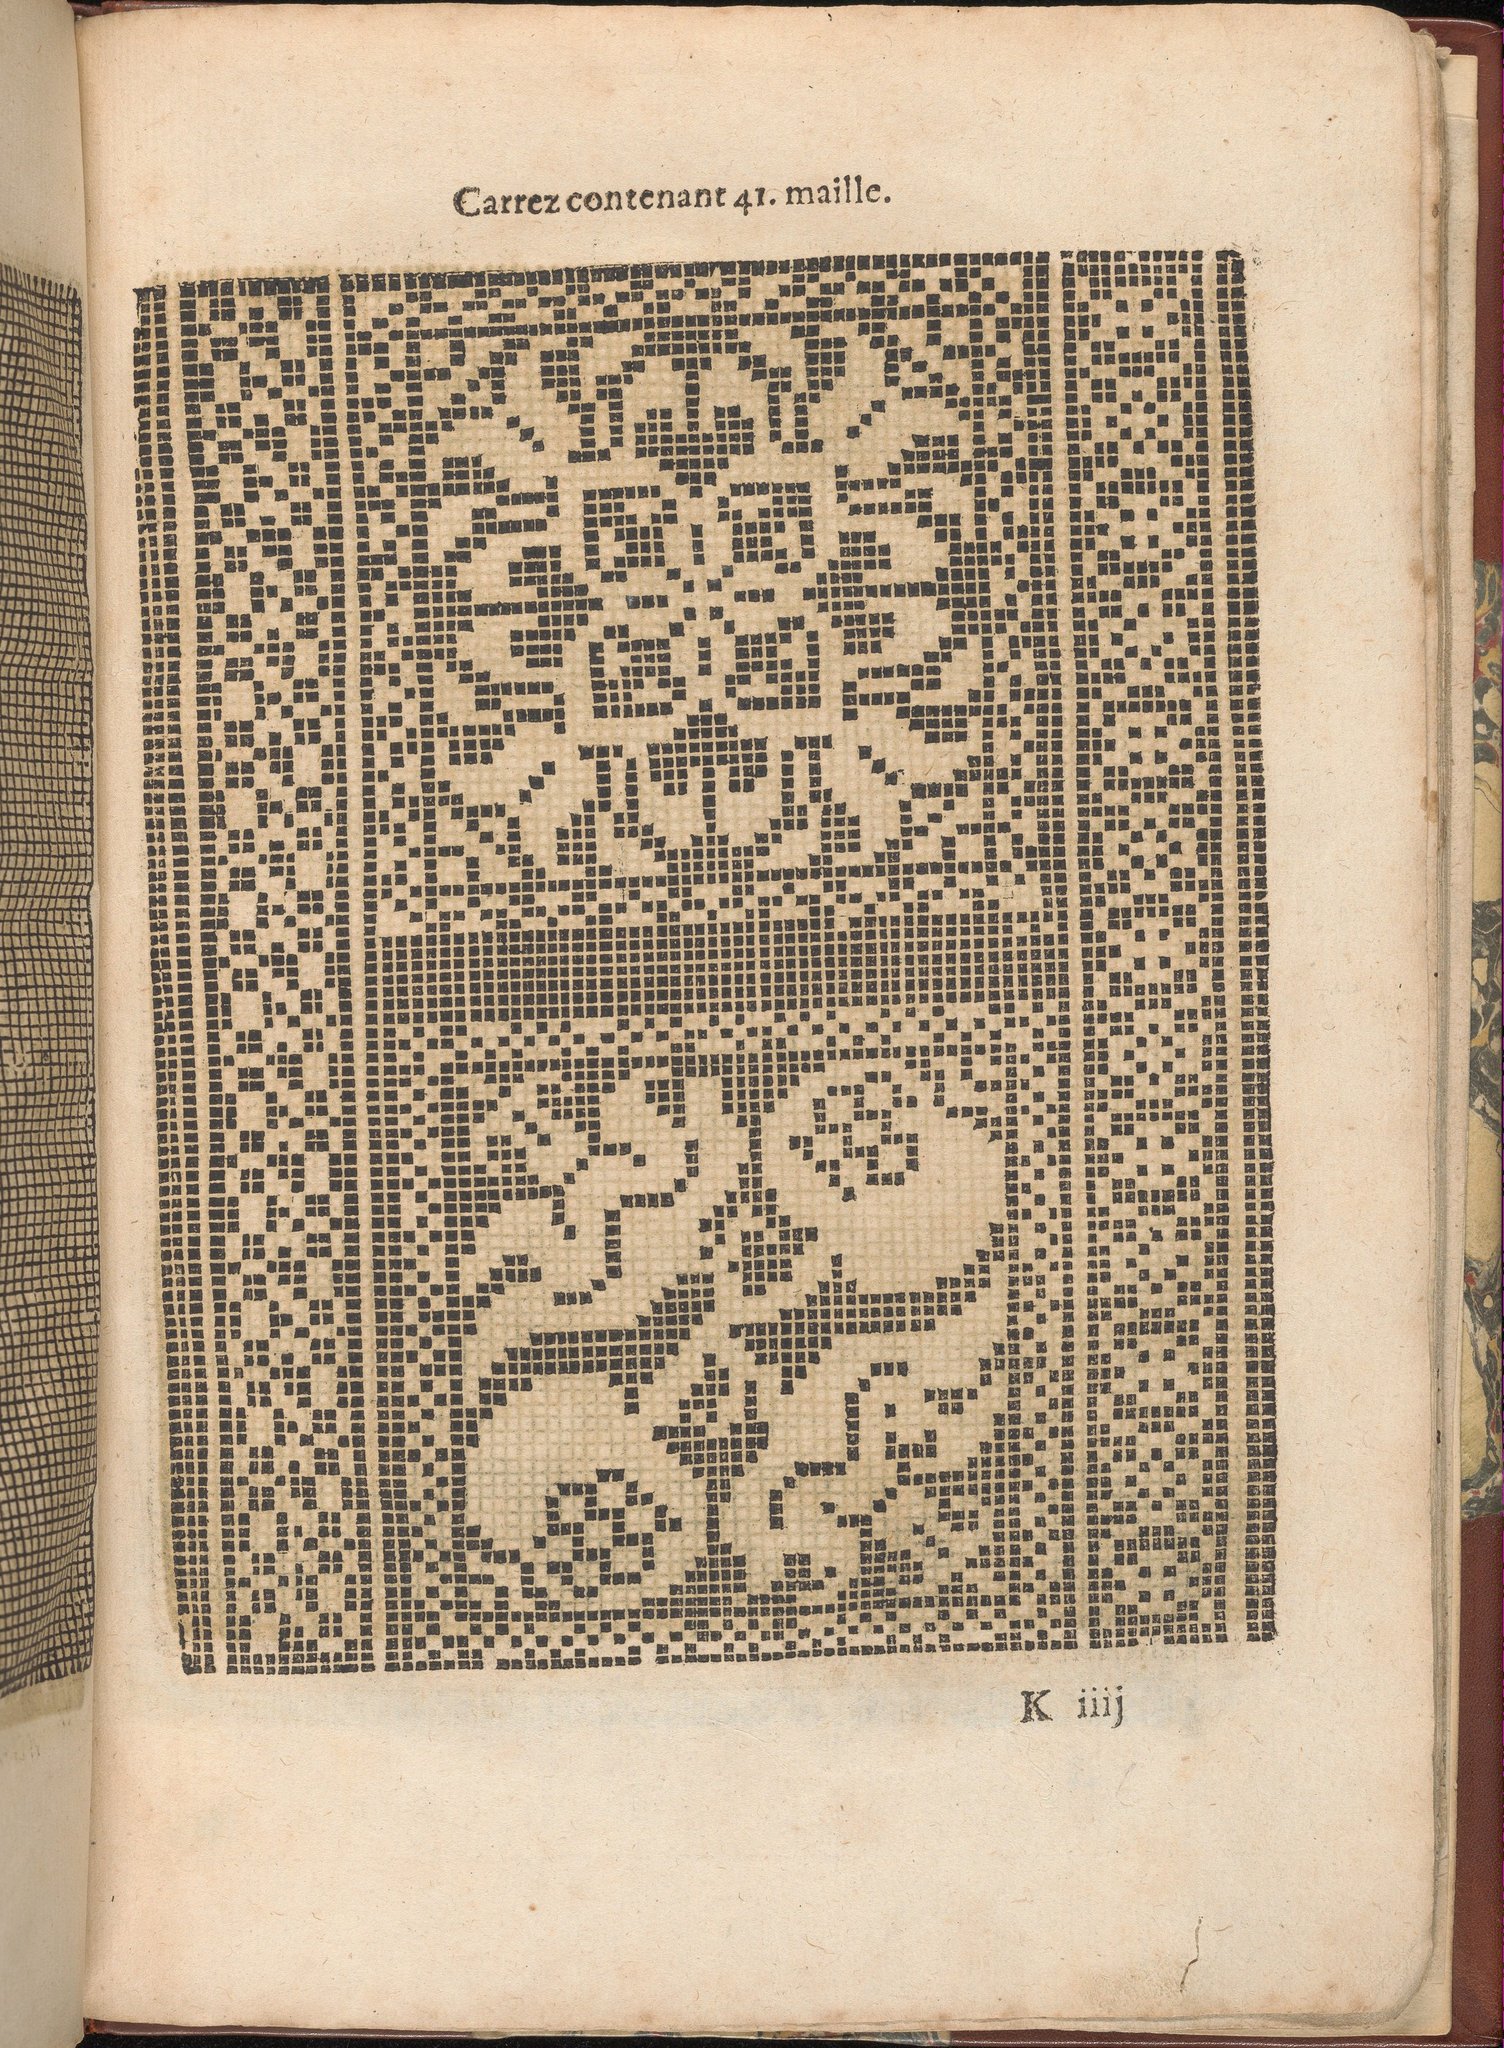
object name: book print ornament architecture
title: Les Secondes Oeuvres, et Subtiles Inventions De Lingerie du Seigneur Federic de Vinciolo Venitien, page 40 (recto)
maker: federico de vinciolo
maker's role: designer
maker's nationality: italian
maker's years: 1582-1599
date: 1603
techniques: woodcut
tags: ornament